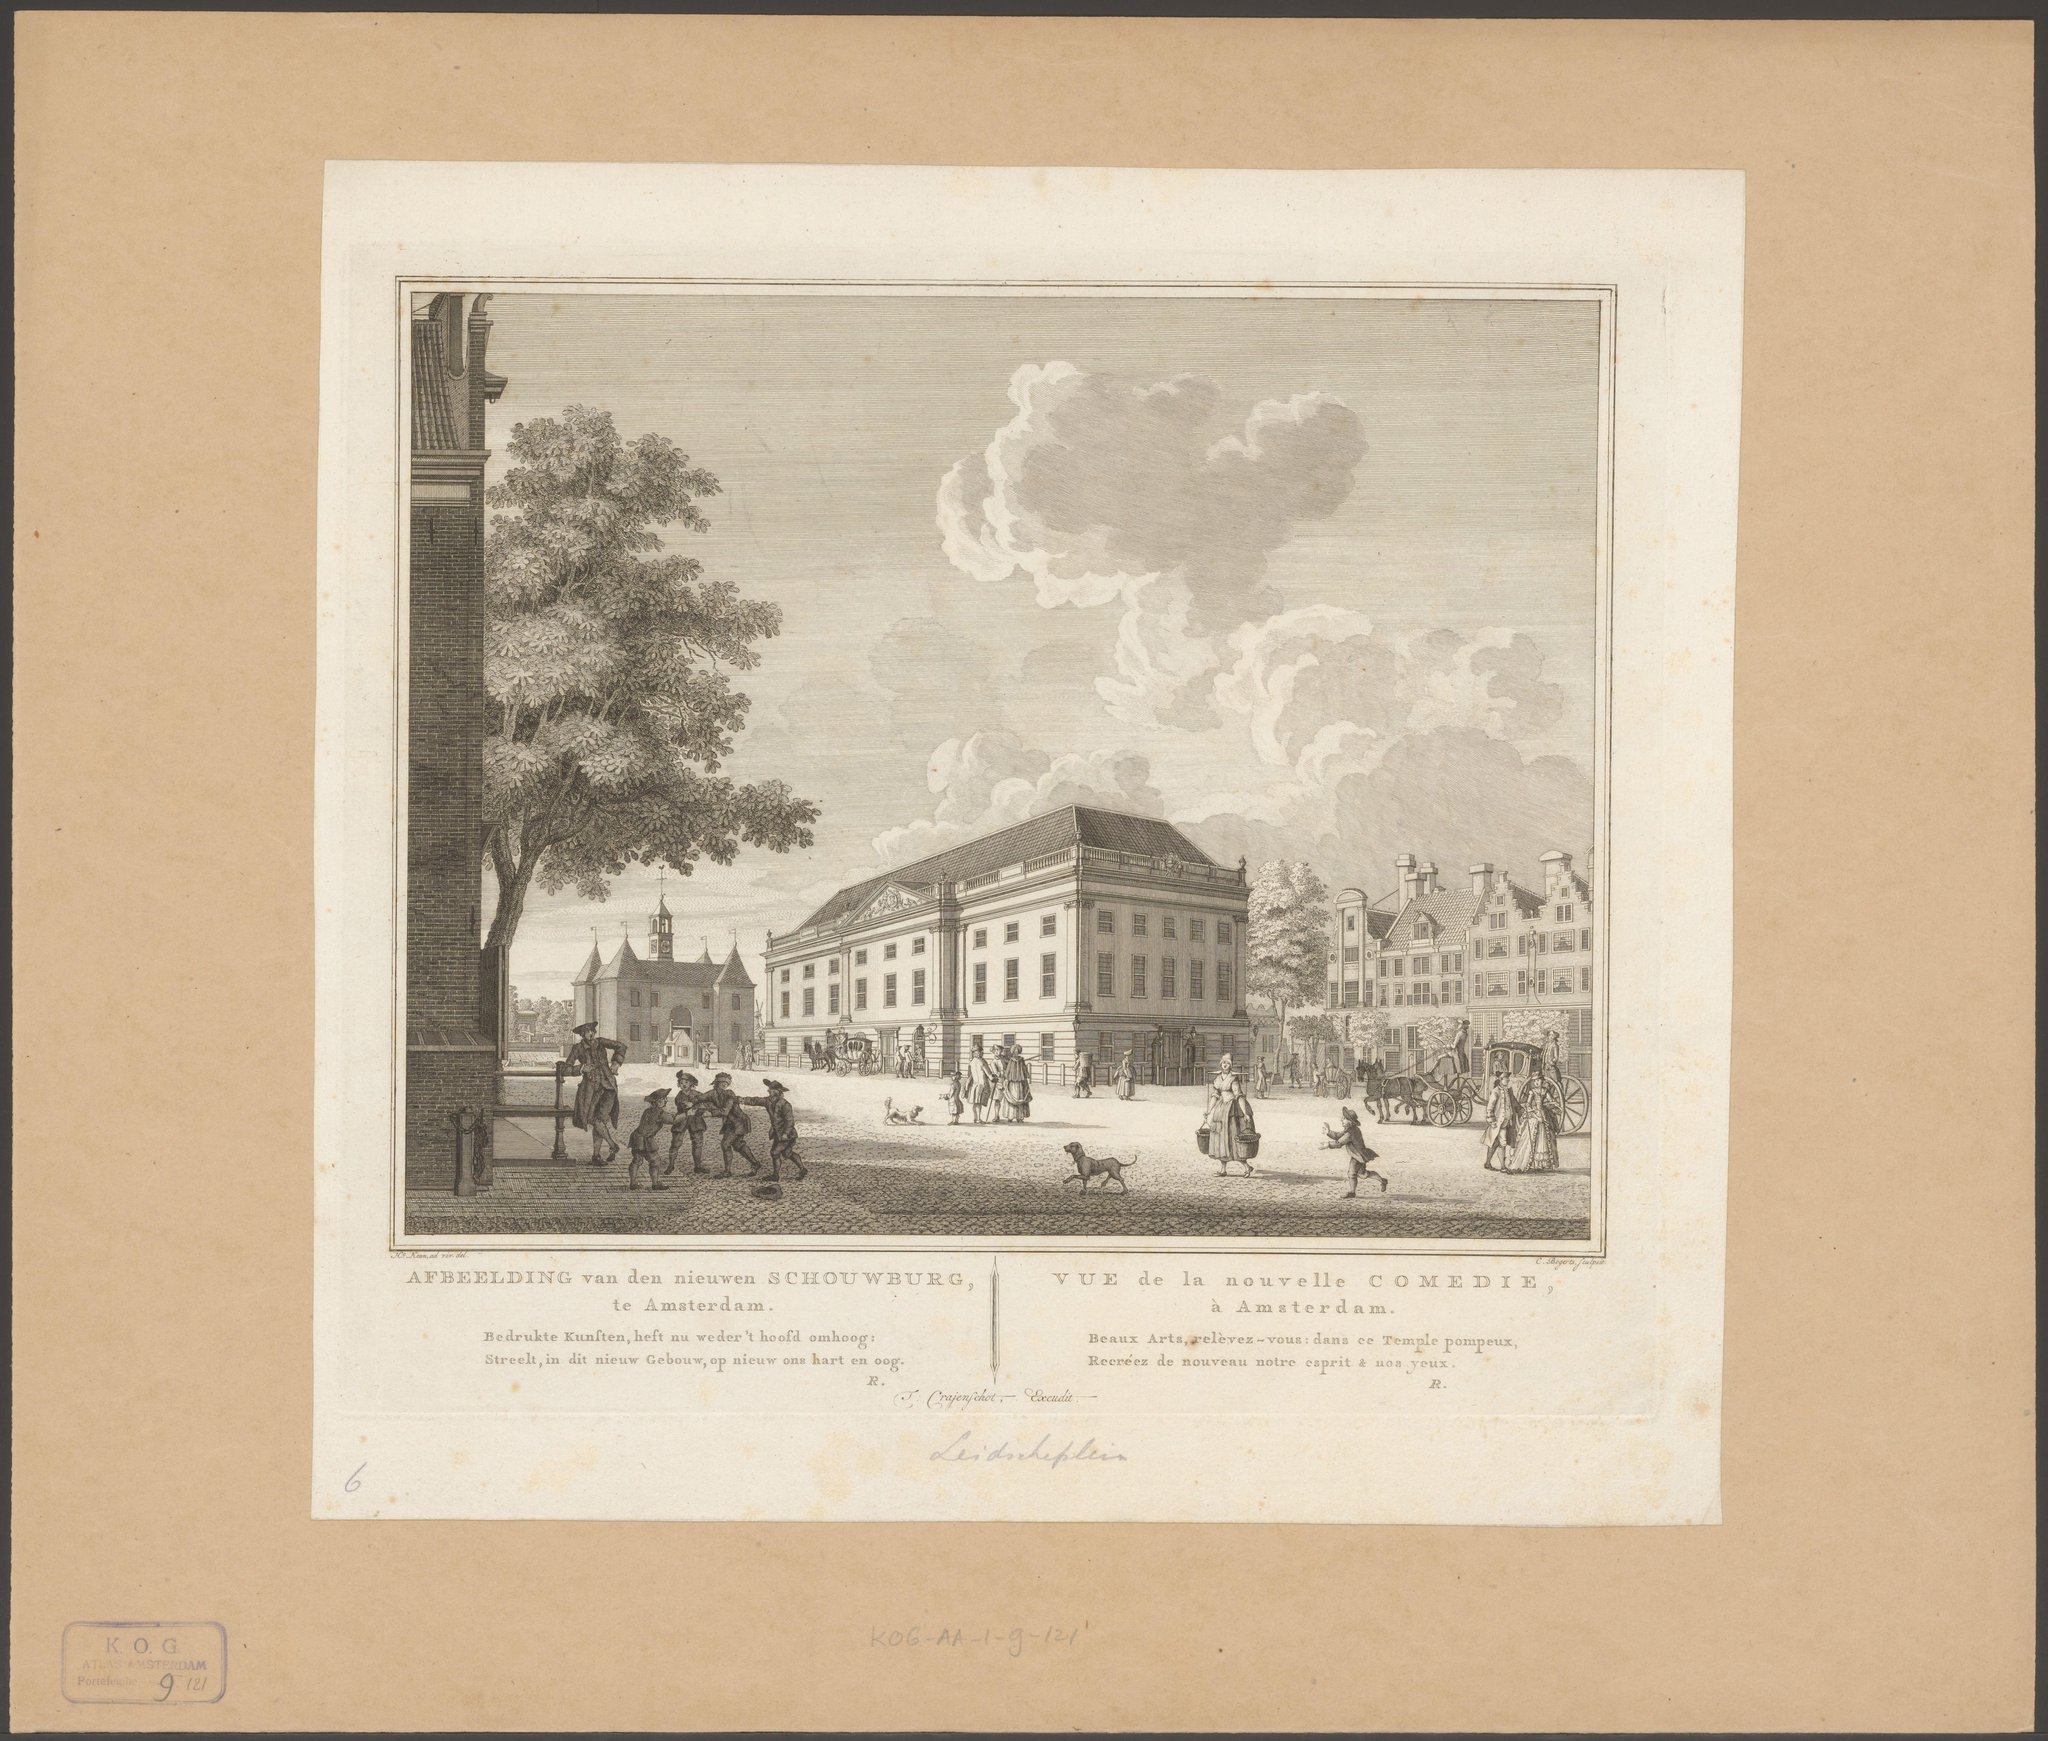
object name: print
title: Gezicht op de schouwburg aan het Leidseplein te Amsterdam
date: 1774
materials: paper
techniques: engraving, etching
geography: amsterdam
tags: square, place, circus, etc., city-view in general; 'veduta', theatre (building), city-gate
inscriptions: collector's mark: ‘9.121’ Lugt 1641b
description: Onderwerpsrubriek binnen de Atlas Amsterdam: 2e Laurierdwarsstraat (Vuile Weespad), Leidschegracht, Leidschekade, Leidscheplein, Leidschestraat, v. Lennepkade, Lijnbaansgracht, Lauriergracht, Leliedwarsstraat, Leliegracht, Lindengracht, Lombardsteeg, Looiersgracht, Looiersstraat (Nieuwe), Leidekkerssteeg.